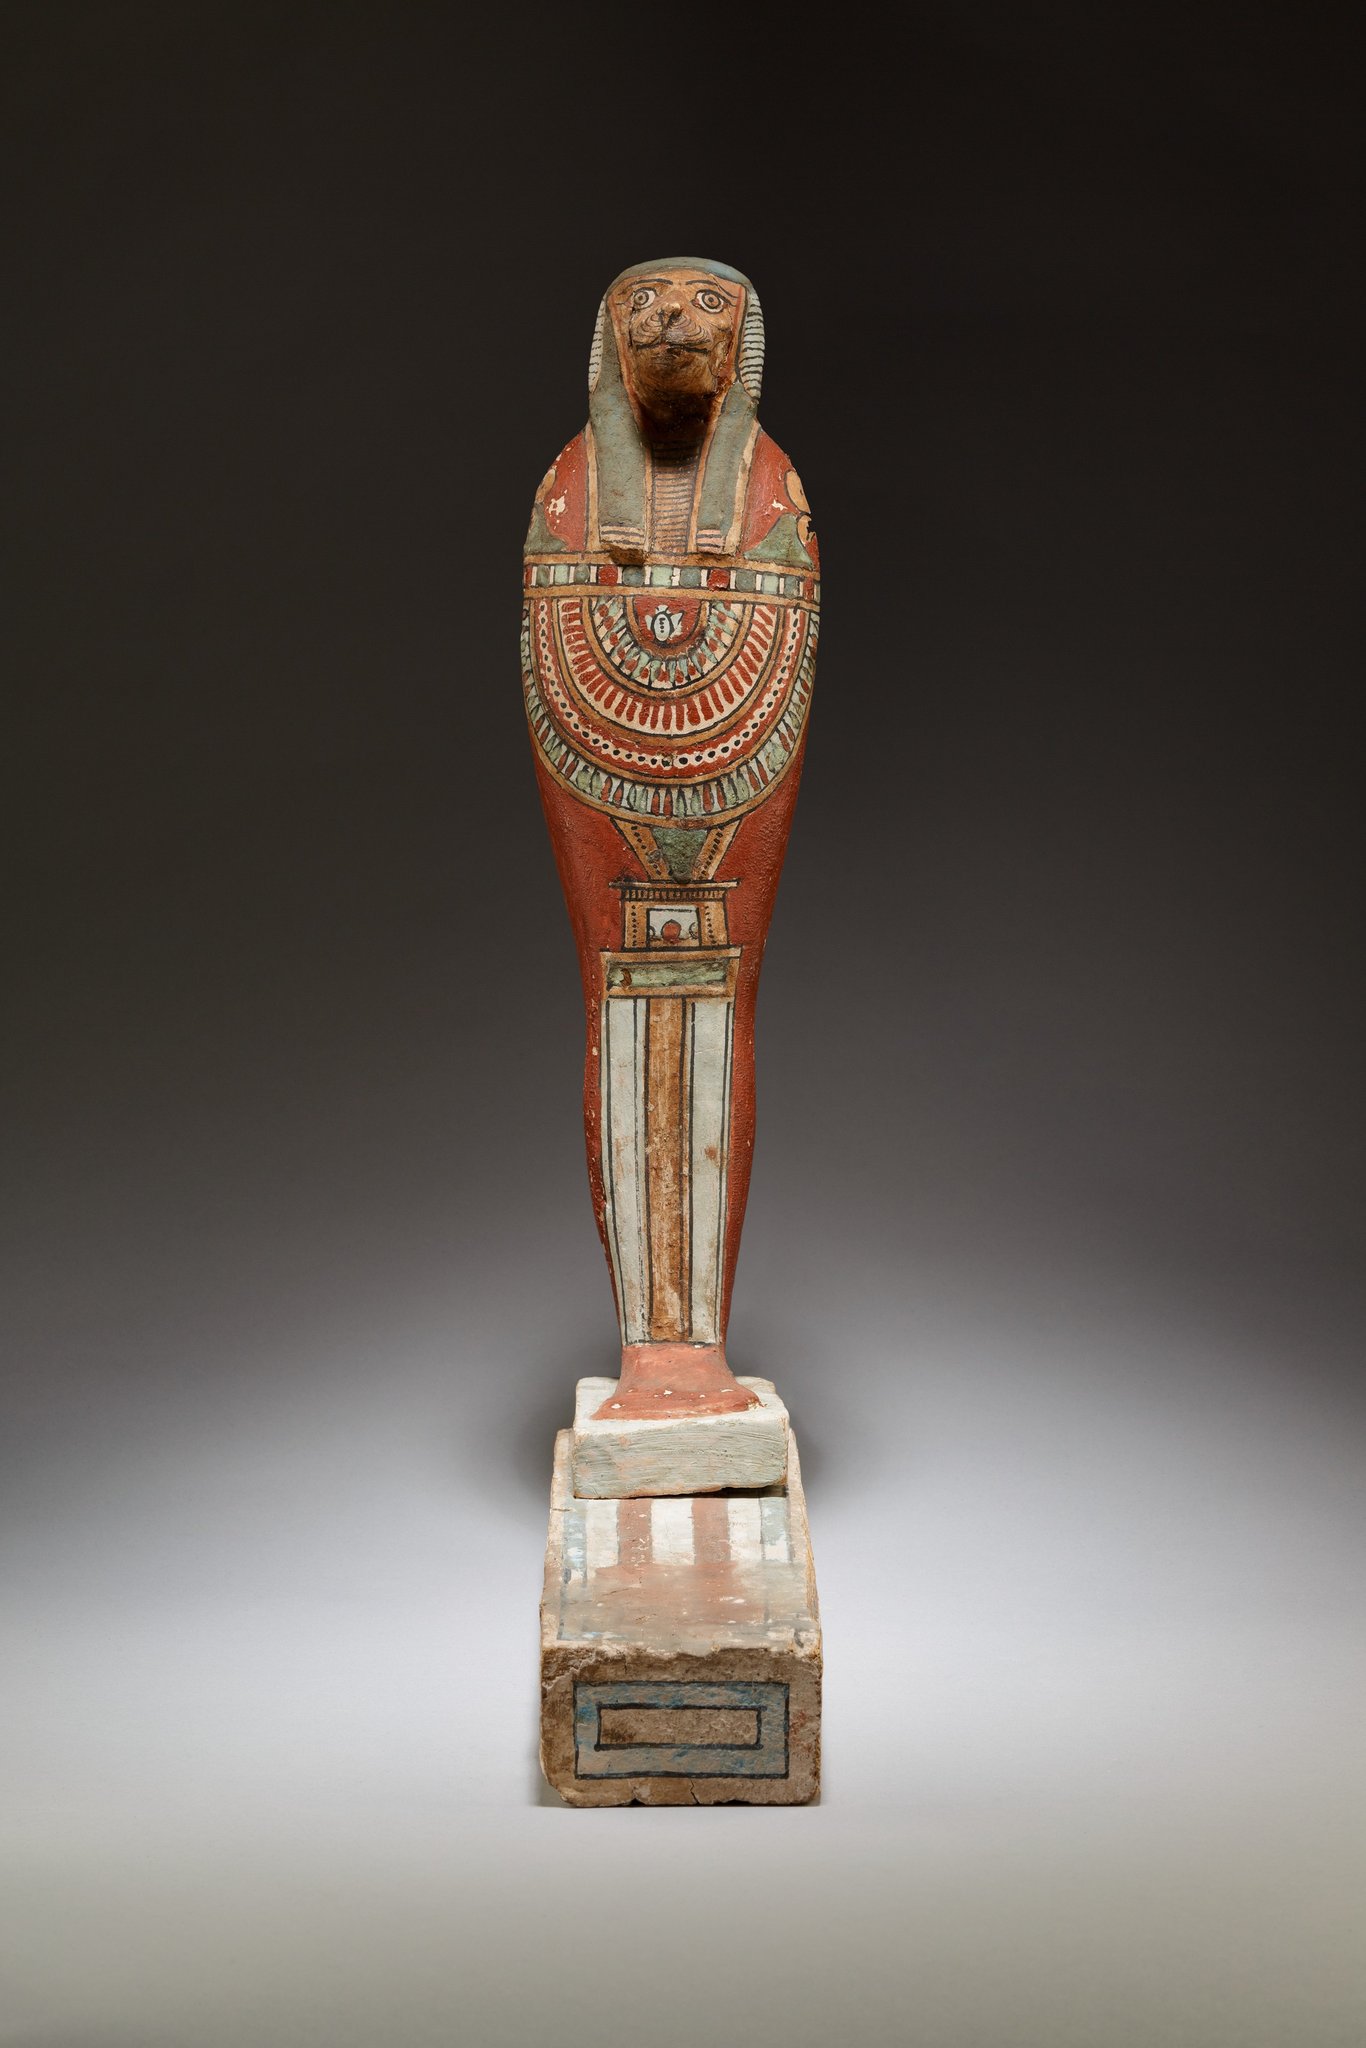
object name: funerary figure, hapy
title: Funerary Figure of Hapy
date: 400-30 BCE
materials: wood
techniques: painting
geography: middle egypt